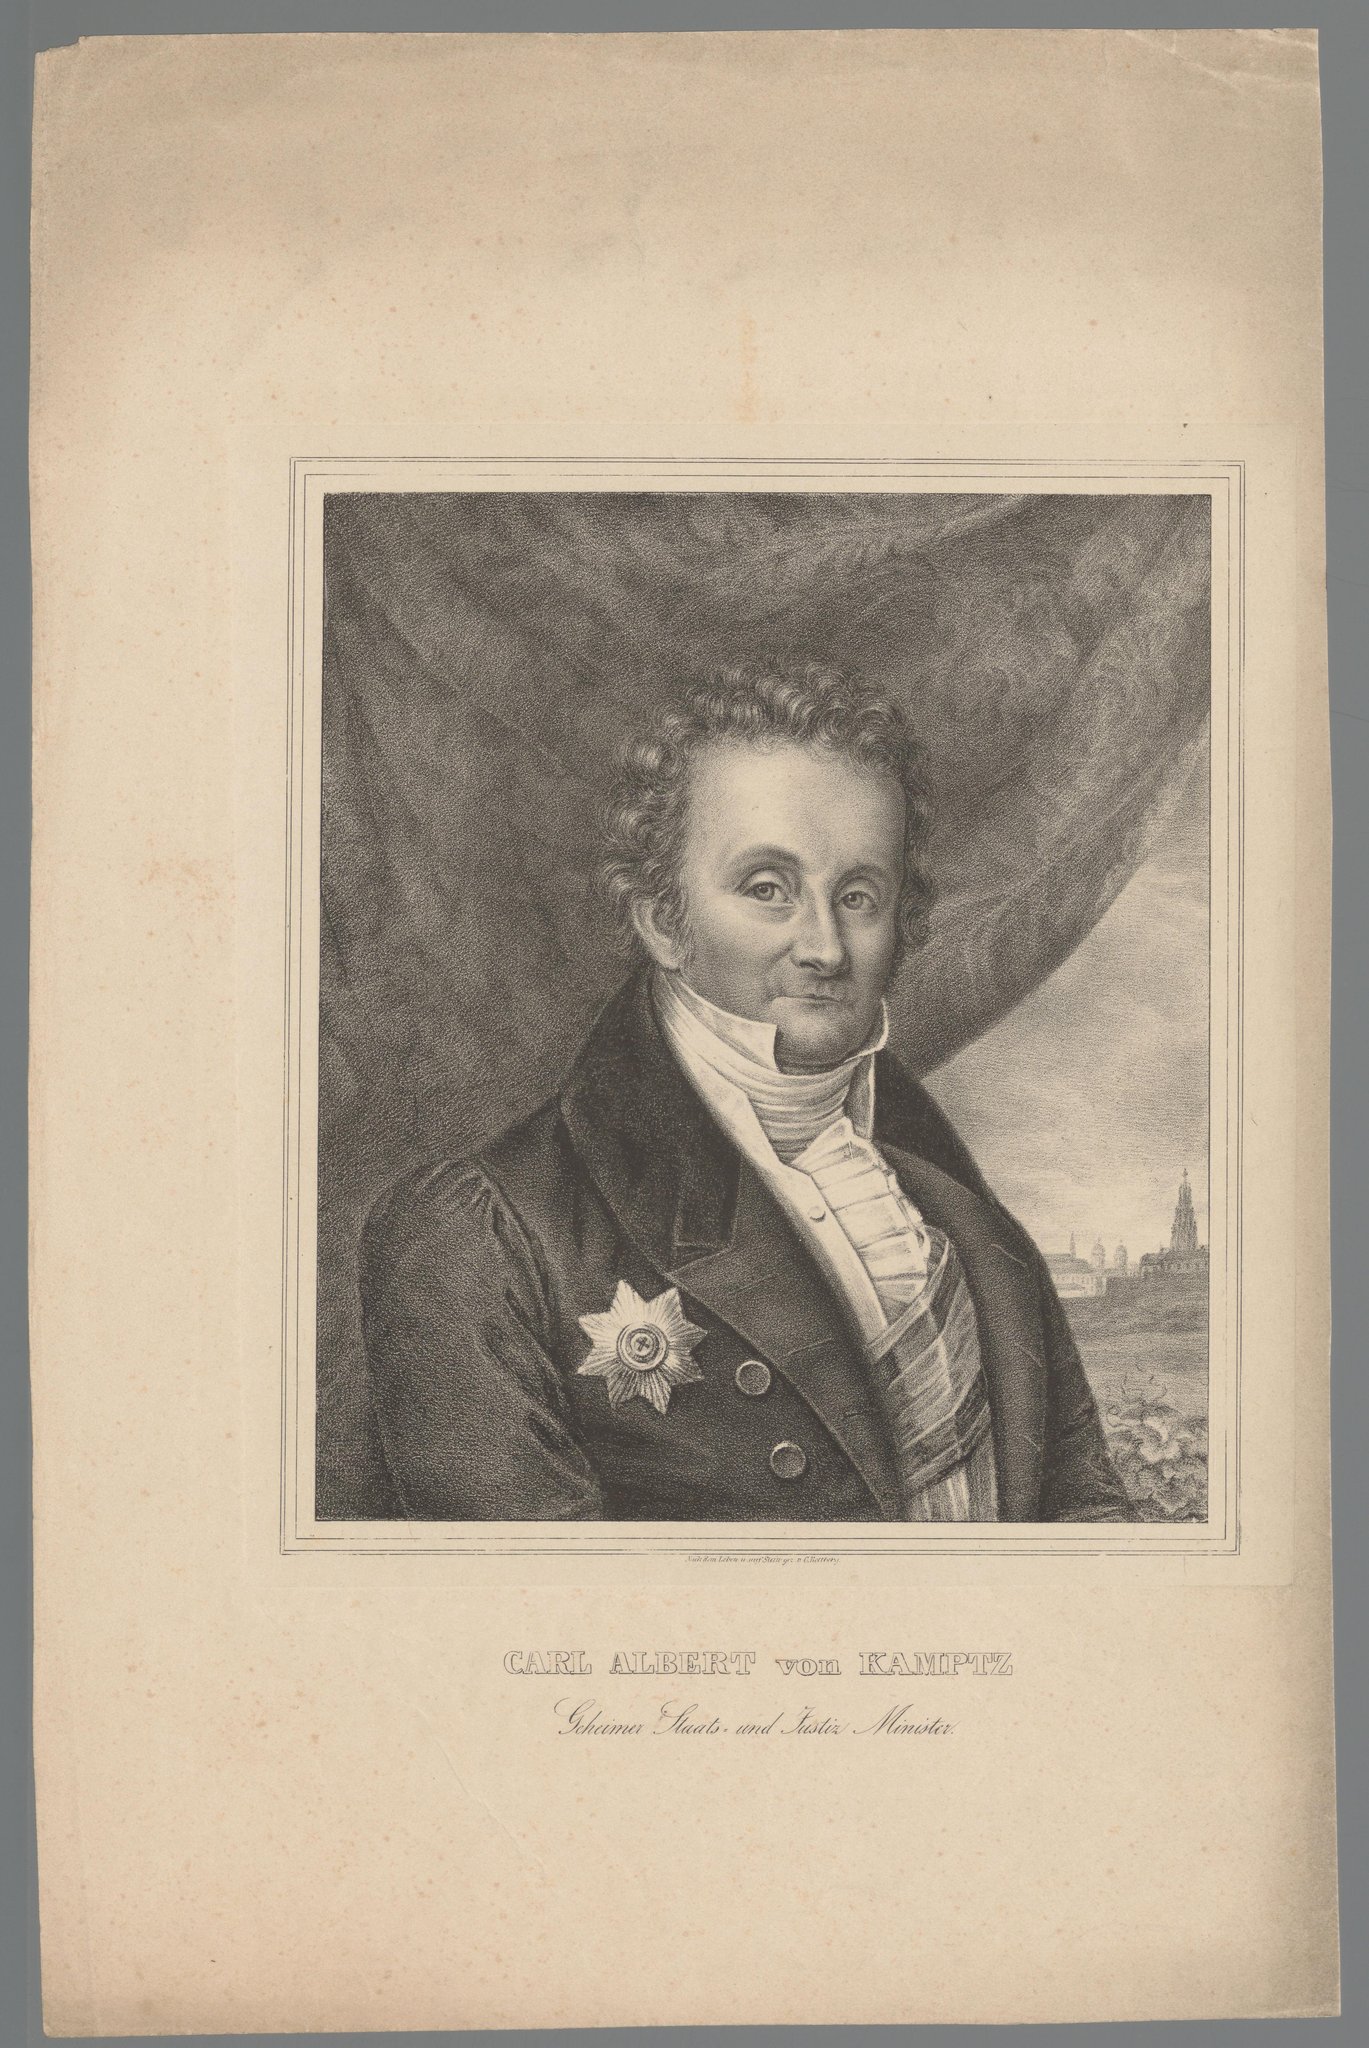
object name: print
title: Portret van Karl Albert von Kamptz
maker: ralf leopold von retberg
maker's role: print maker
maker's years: 1812-1885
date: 1822-1885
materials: paper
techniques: lithograph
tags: berlin, historical persons, law and jurisprudence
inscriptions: collector's mark: Lugt 2228